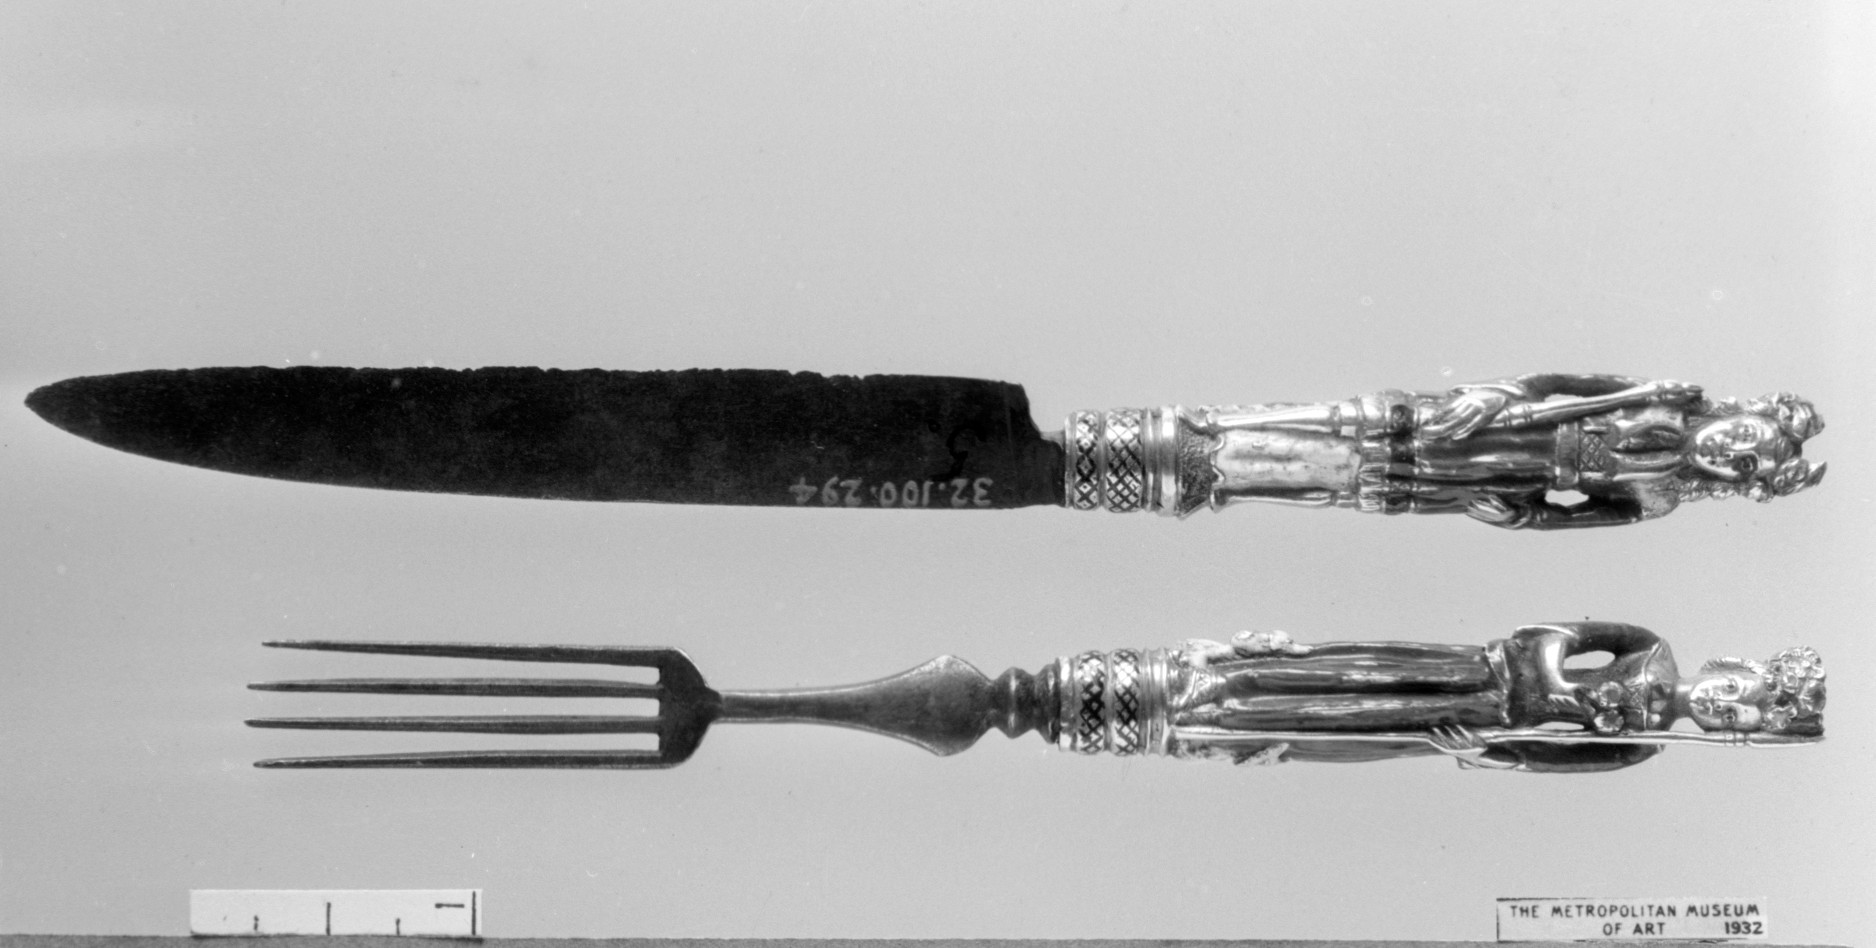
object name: knife and fork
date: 1601-1700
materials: enamel, gold, steel